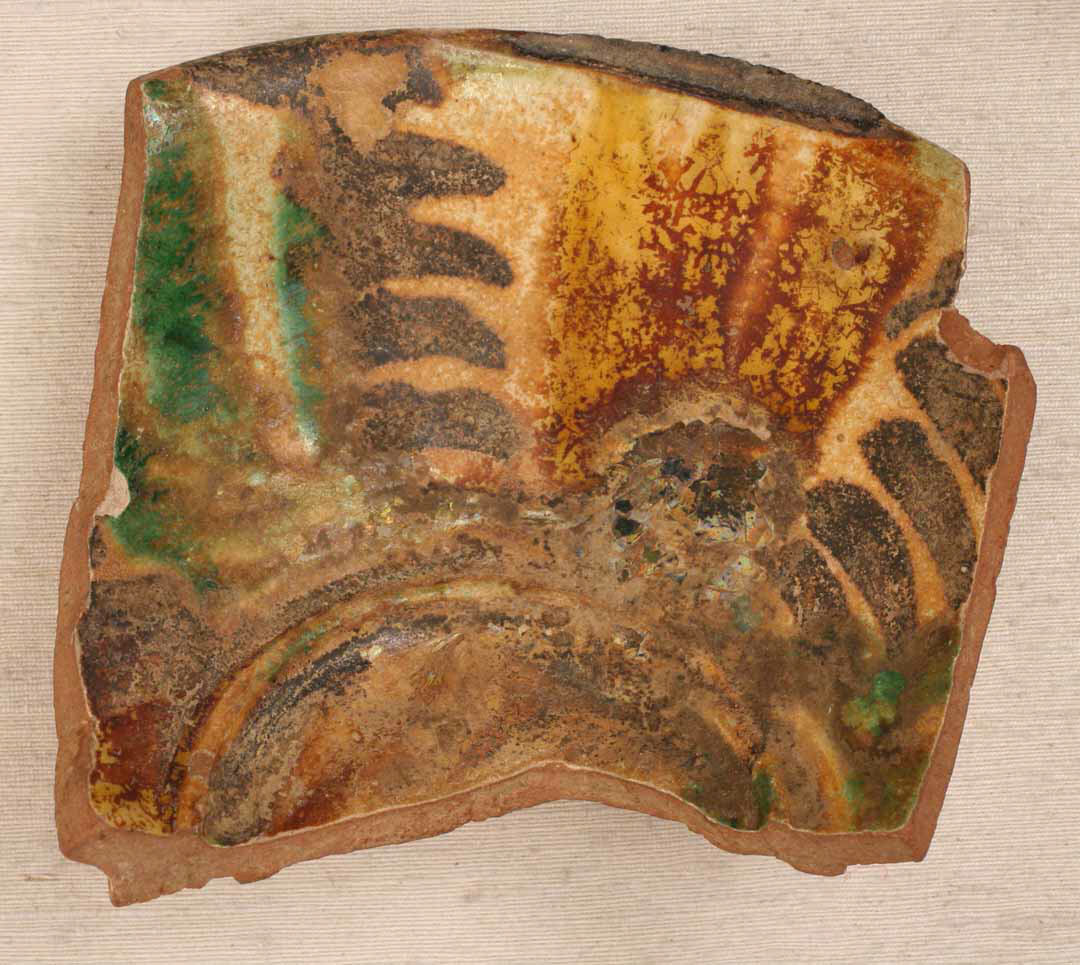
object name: fragment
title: Ceramic Fragment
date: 701-900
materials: earthenware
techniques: glazing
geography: iraq